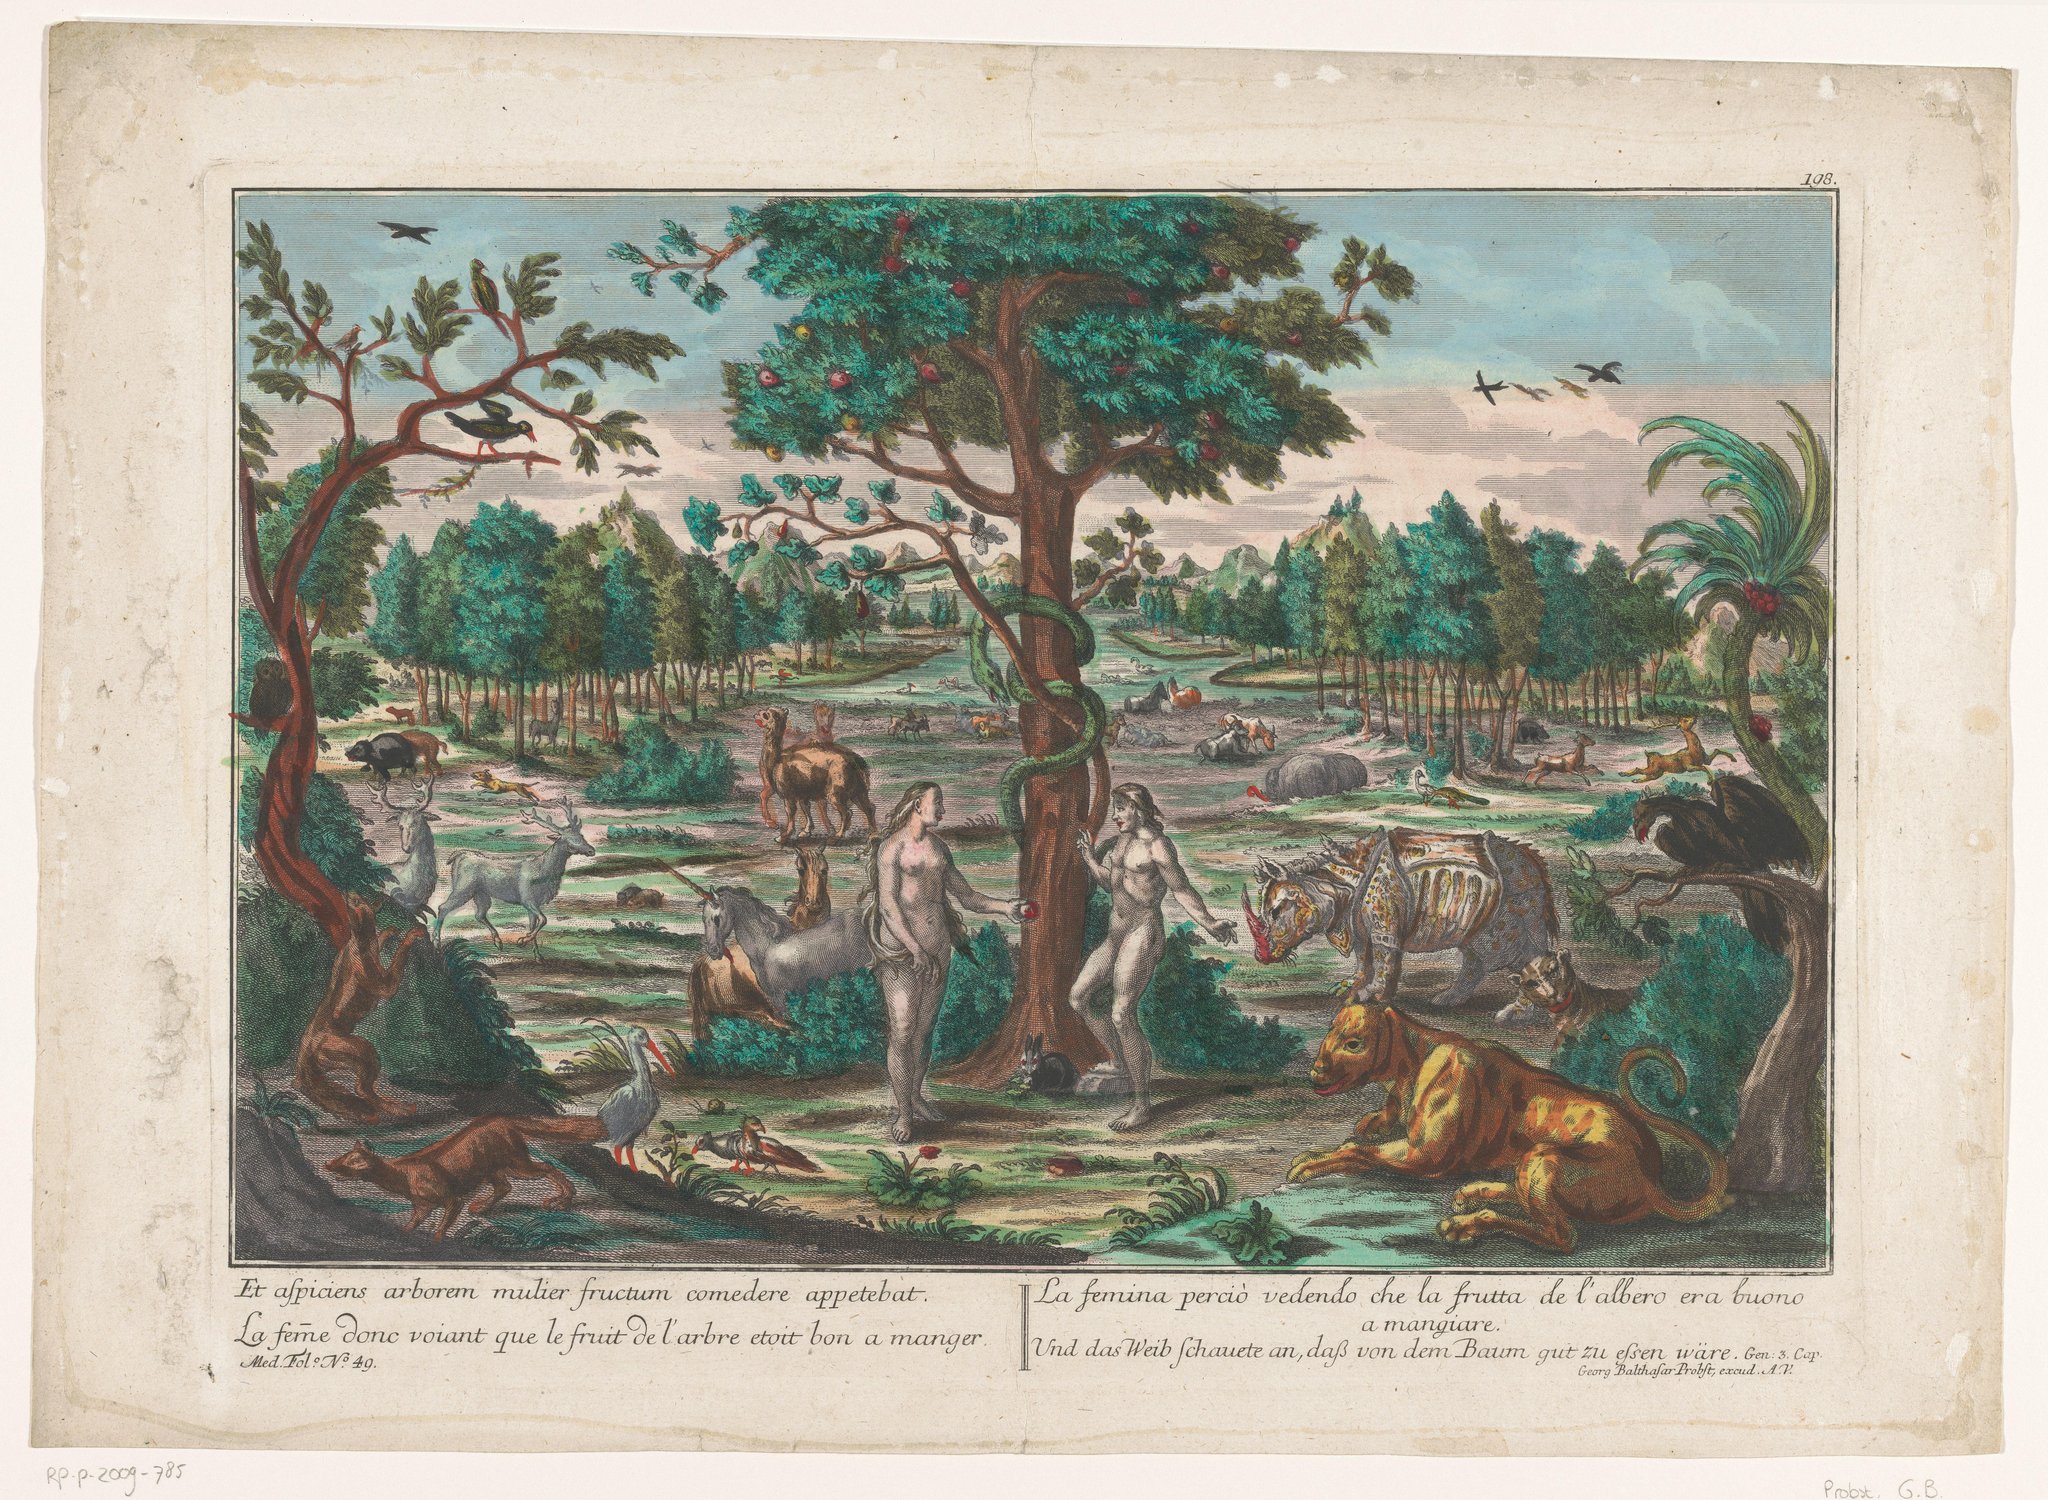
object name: print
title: Hof van Eden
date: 1742-1801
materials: paper, watercolor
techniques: brush, etching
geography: augsburg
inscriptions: collector's mark: Lugt 2228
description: Adam en Eva staan ter weerszijden van een boom met vruchten in een weids landschap met veel dieren. Om de stam van de boom kronkelt een slang. Onder de afbeelding de titel in vier talen.